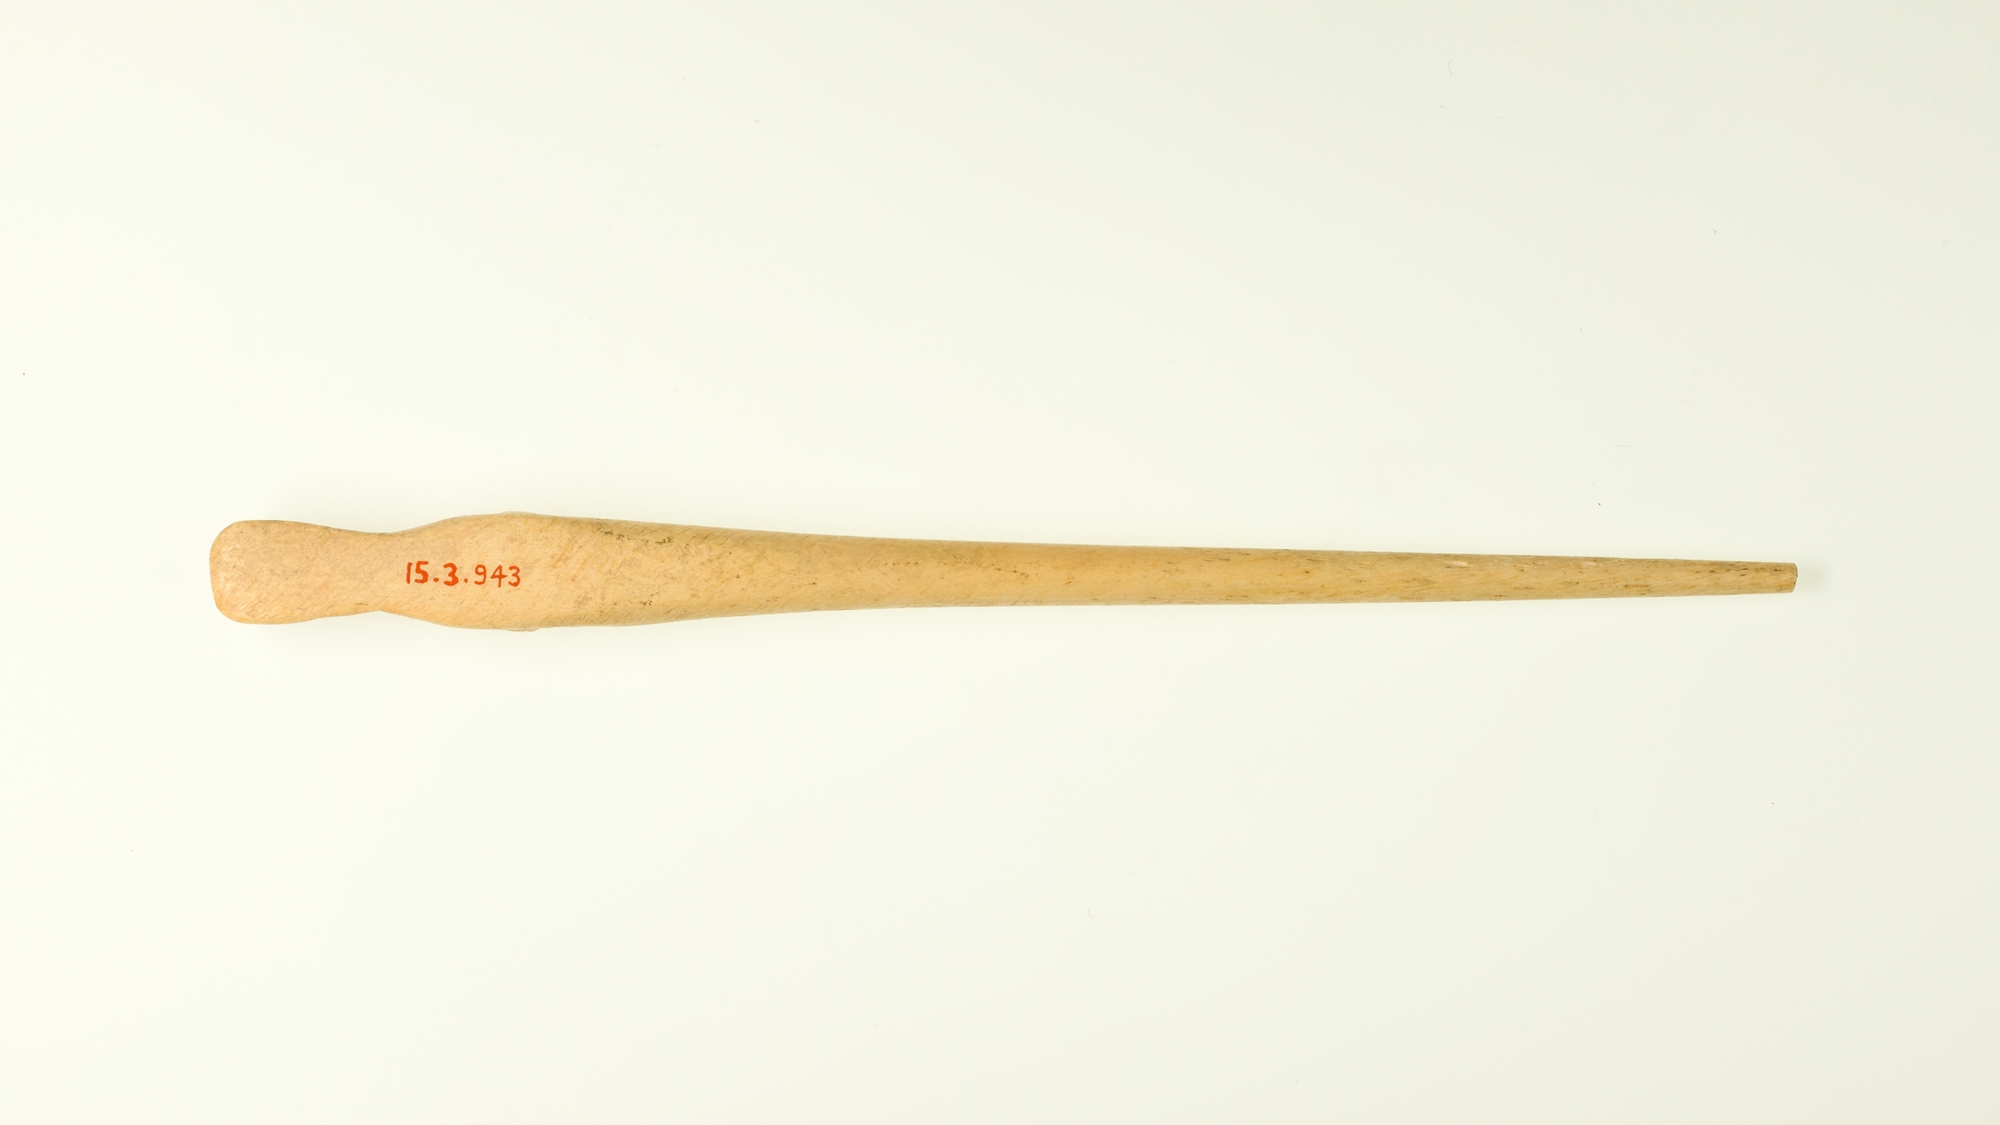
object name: hair pin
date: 1295-1070 BCE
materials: bone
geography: egypt